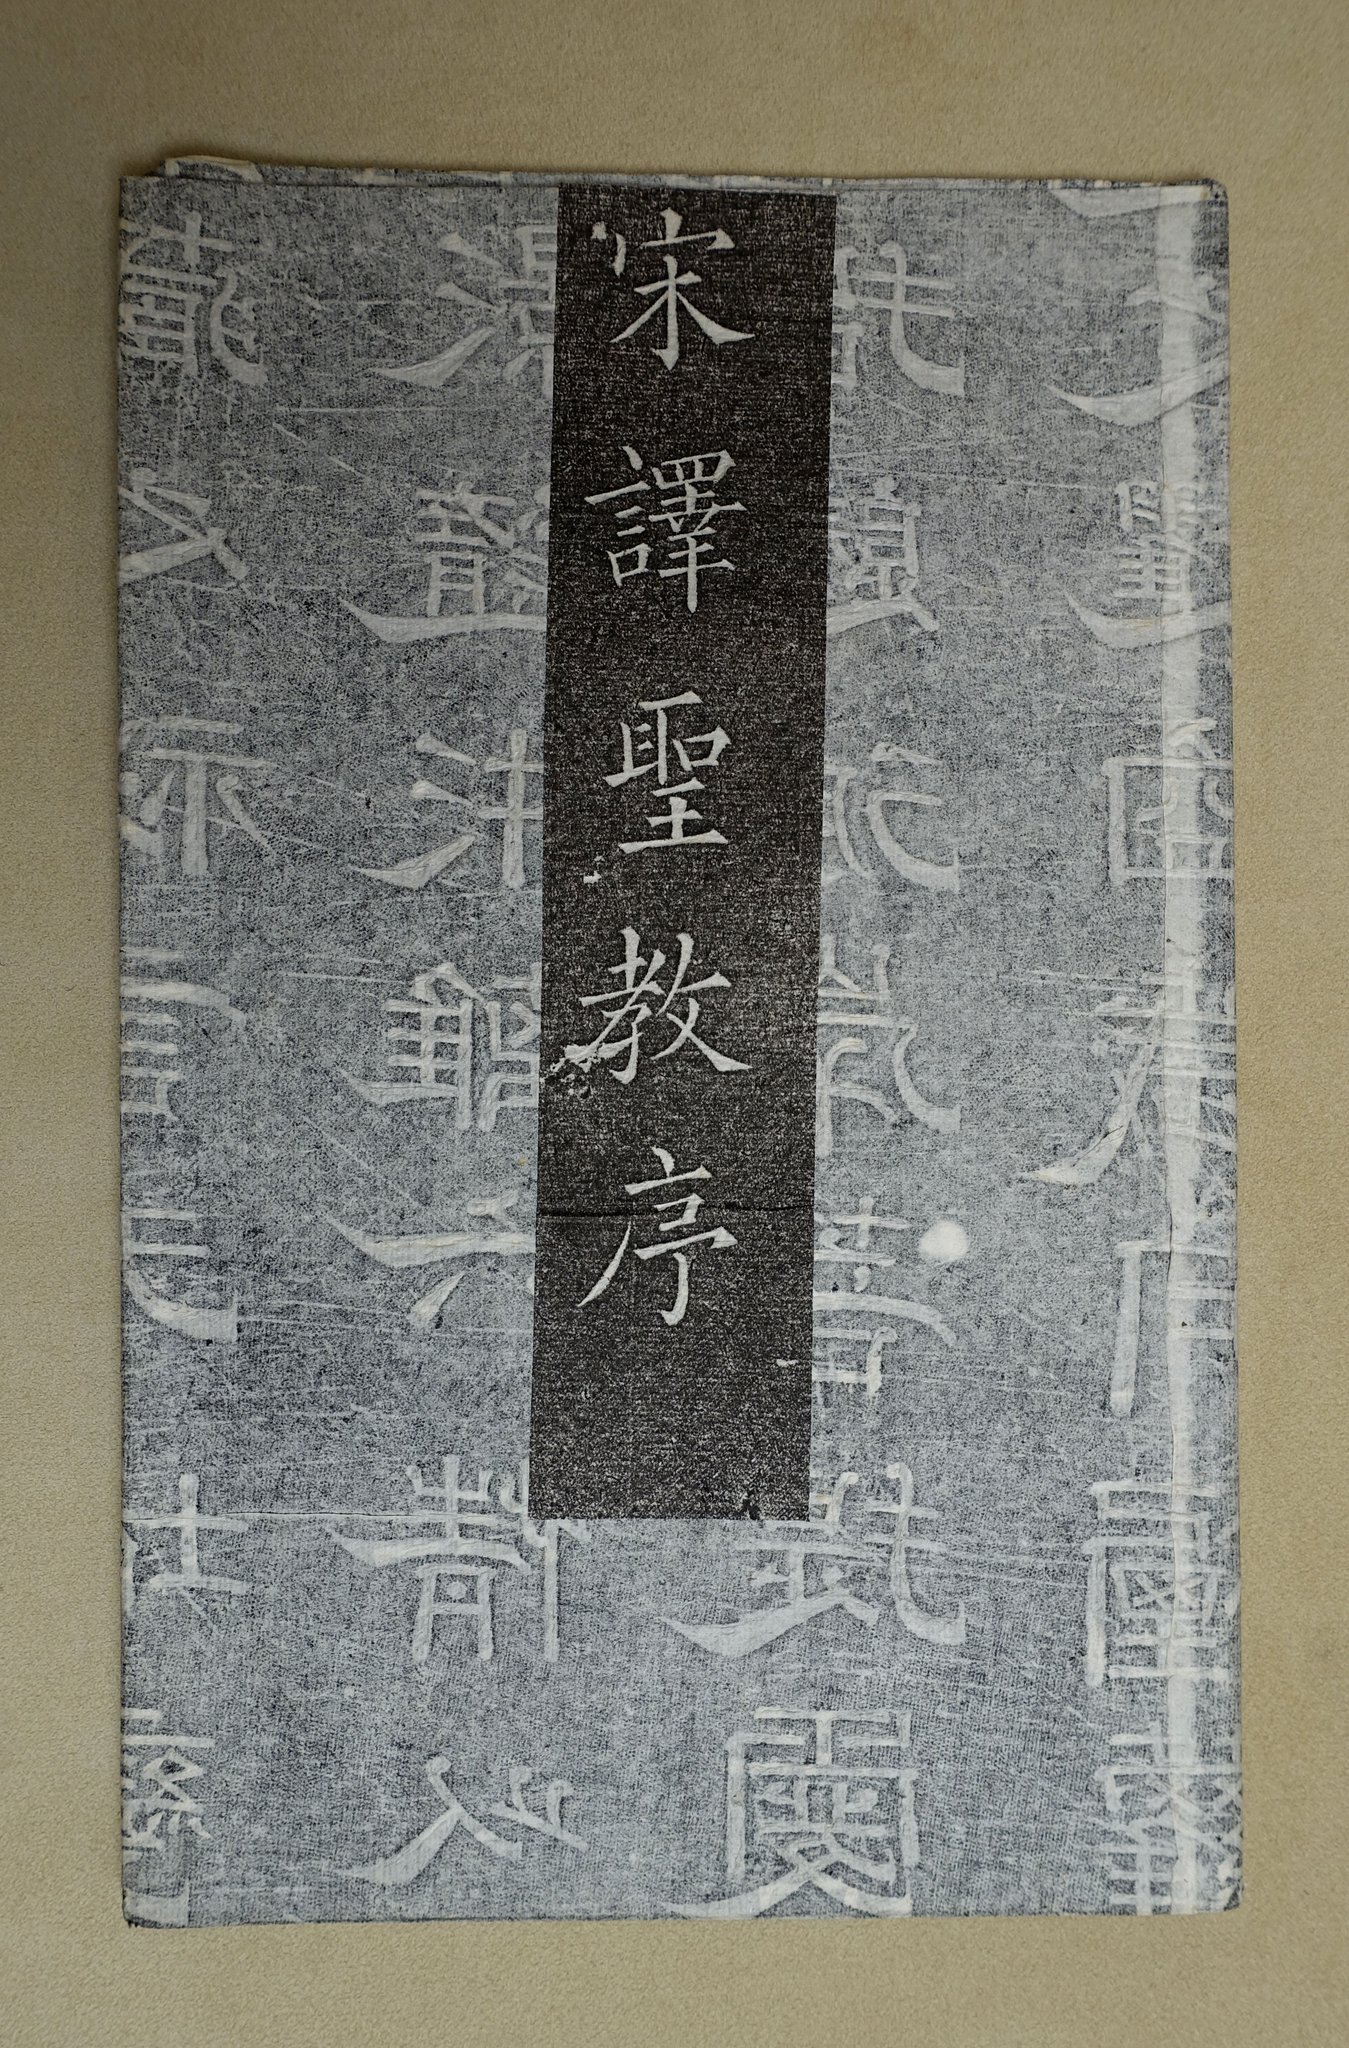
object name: rubbing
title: Preface to a New Translation of the Tripitaka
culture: chinese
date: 1901-2000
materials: ink, paper